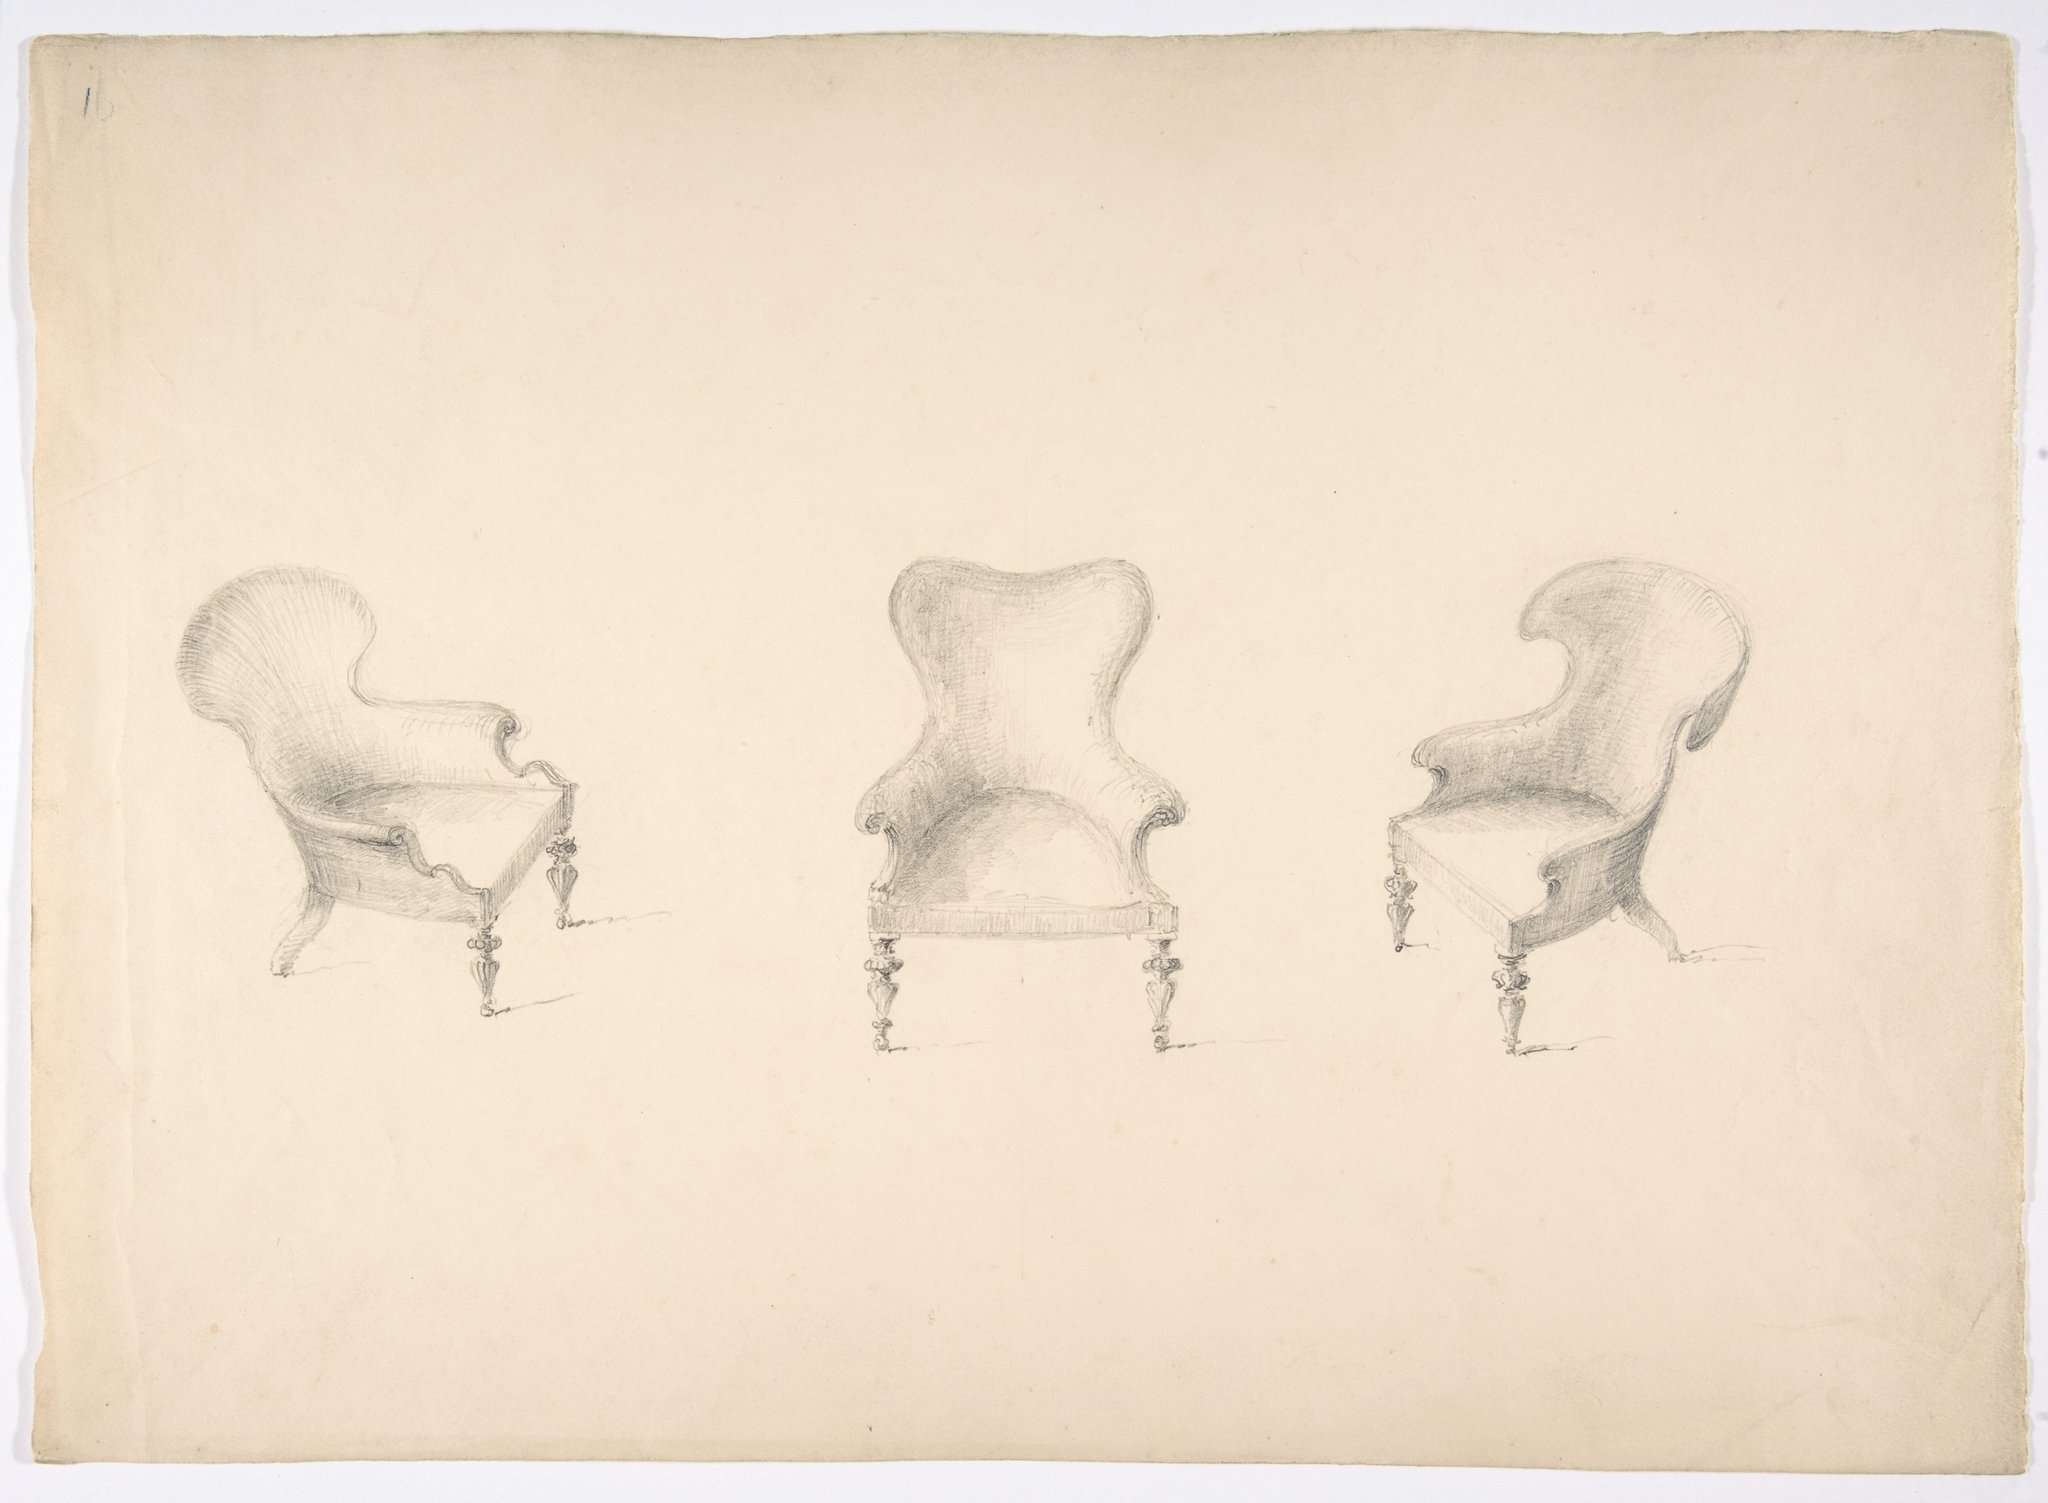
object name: drawing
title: Design for Three Low Uphostered Arm Chairs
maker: anonymous, british, 19th century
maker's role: artist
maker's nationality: british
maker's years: 1800-1900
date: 1801-1833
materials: graphite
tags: chairs